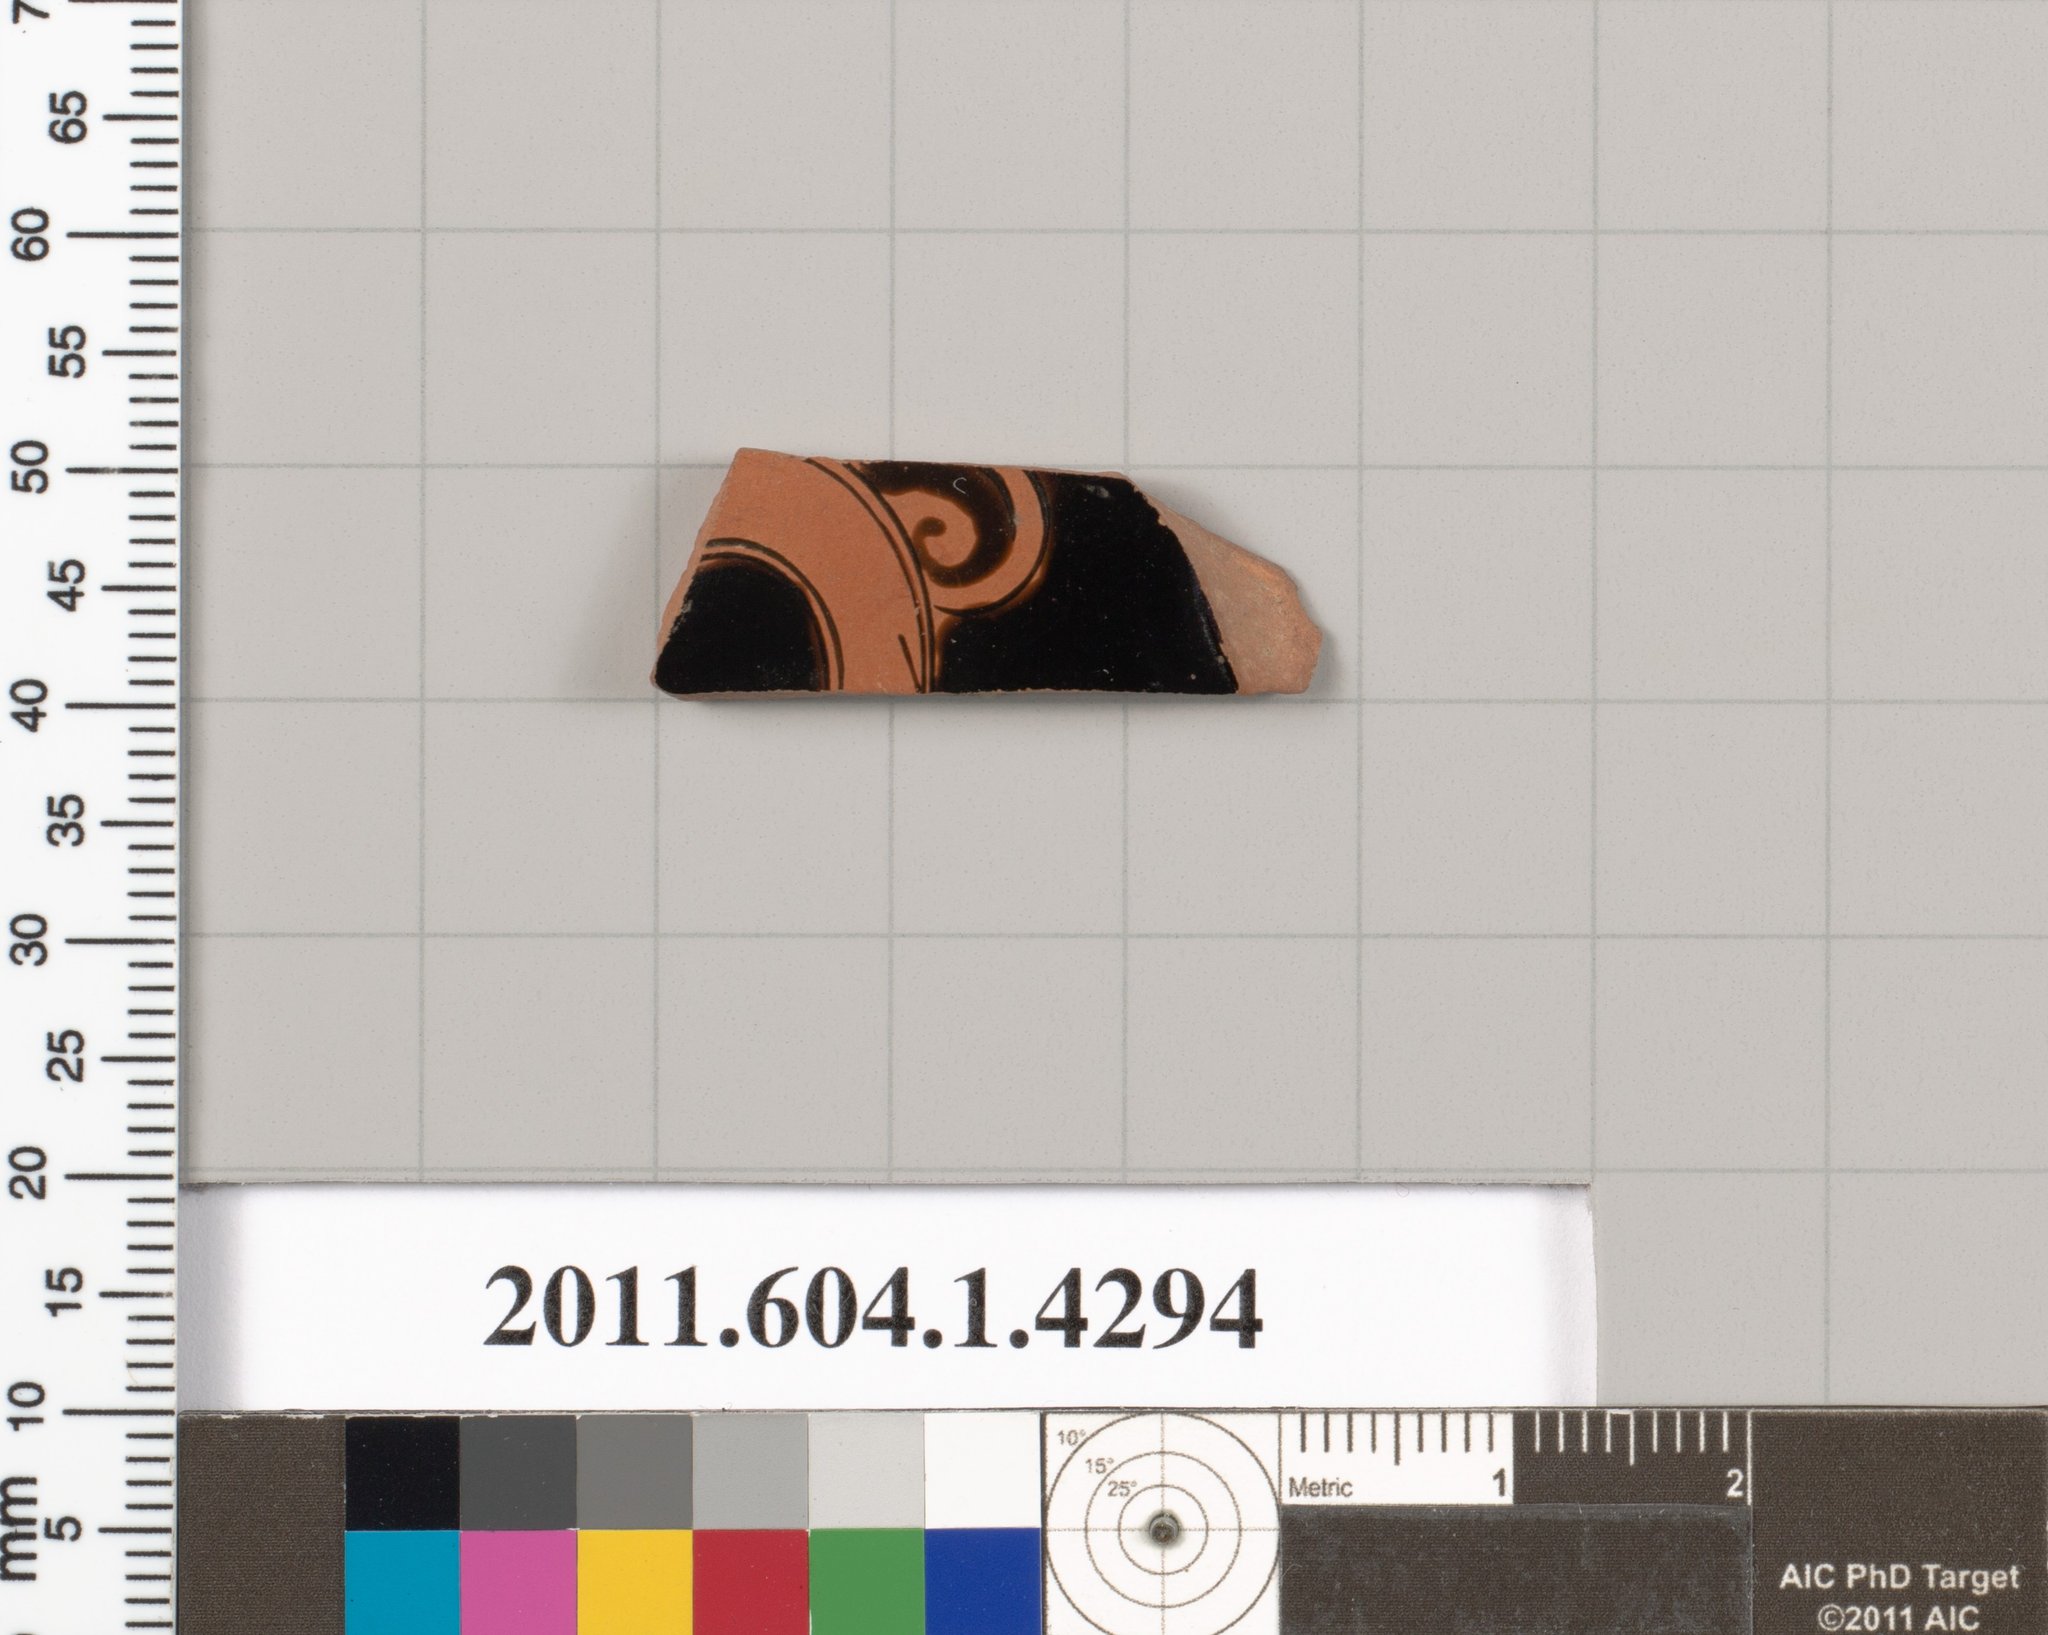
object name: kylix fragment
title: Terracotta fragment of a kylix (drinking cup)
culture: greek, attic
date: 490-470 BCE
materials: terracotta